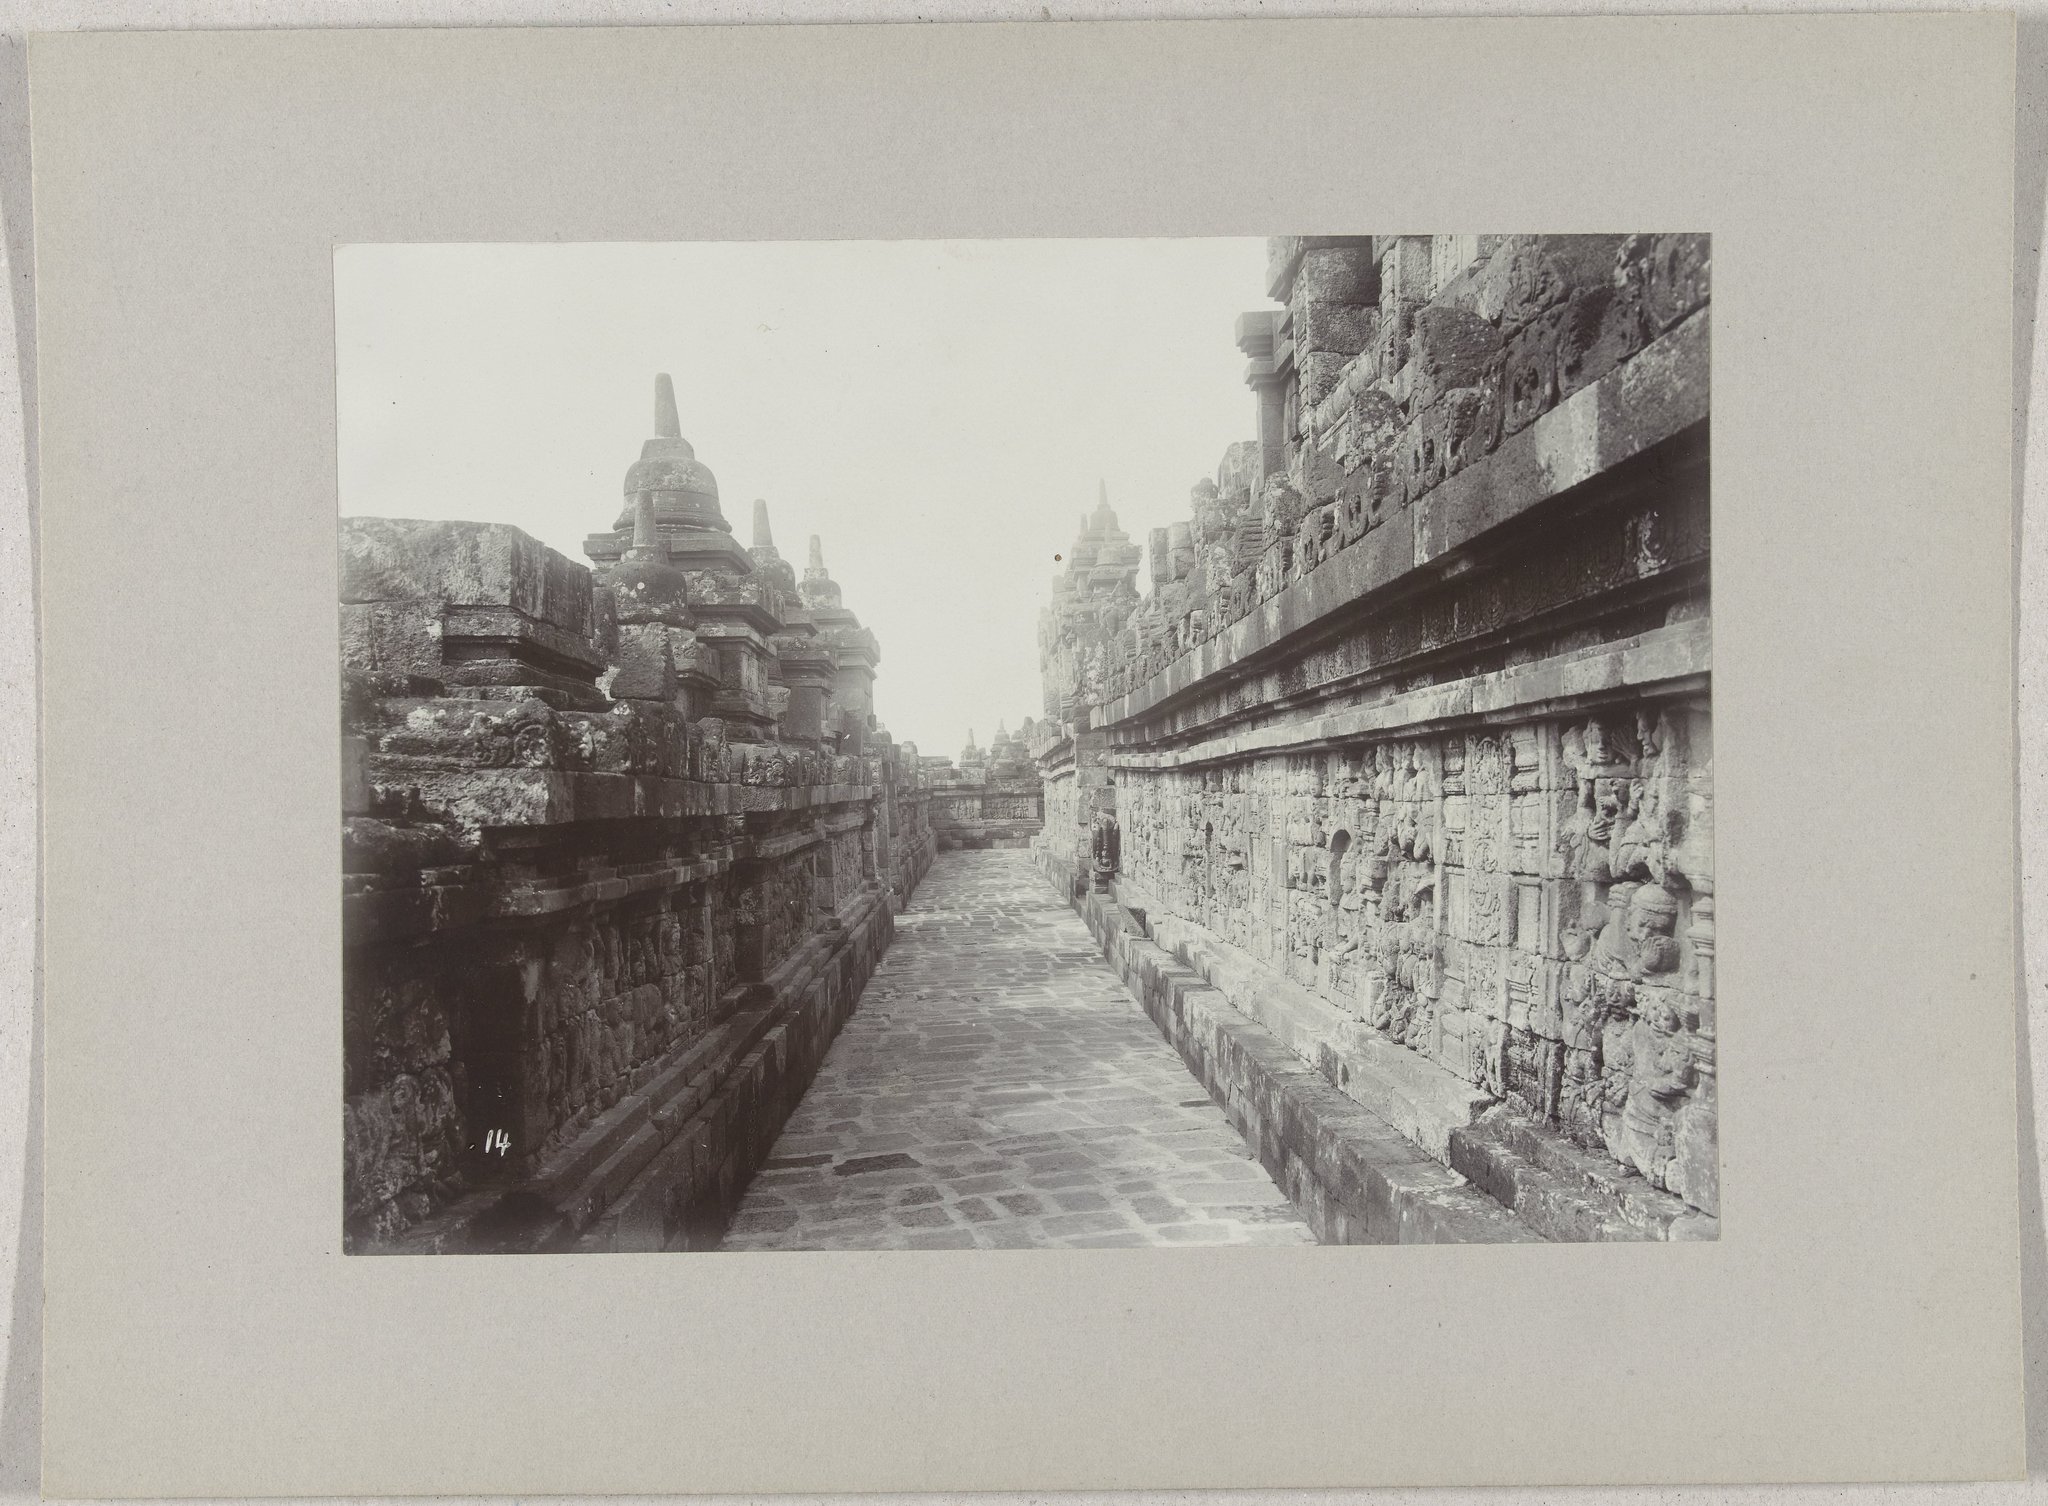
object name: photograph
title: 79. Boroboedoer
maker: onnes kurkdjian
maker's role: fotograaf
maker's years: 1851-1903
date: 1895-1915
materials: cardboard, paper, photographic support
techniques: gelatin silver print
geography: magelang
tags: borobudur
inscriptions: number: ‘14’, annotation: ‘79. Boroboedoer’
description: Gaanderij van de Borobudur (Boroboedoer), nabij Magelang, Nederlands-Indië